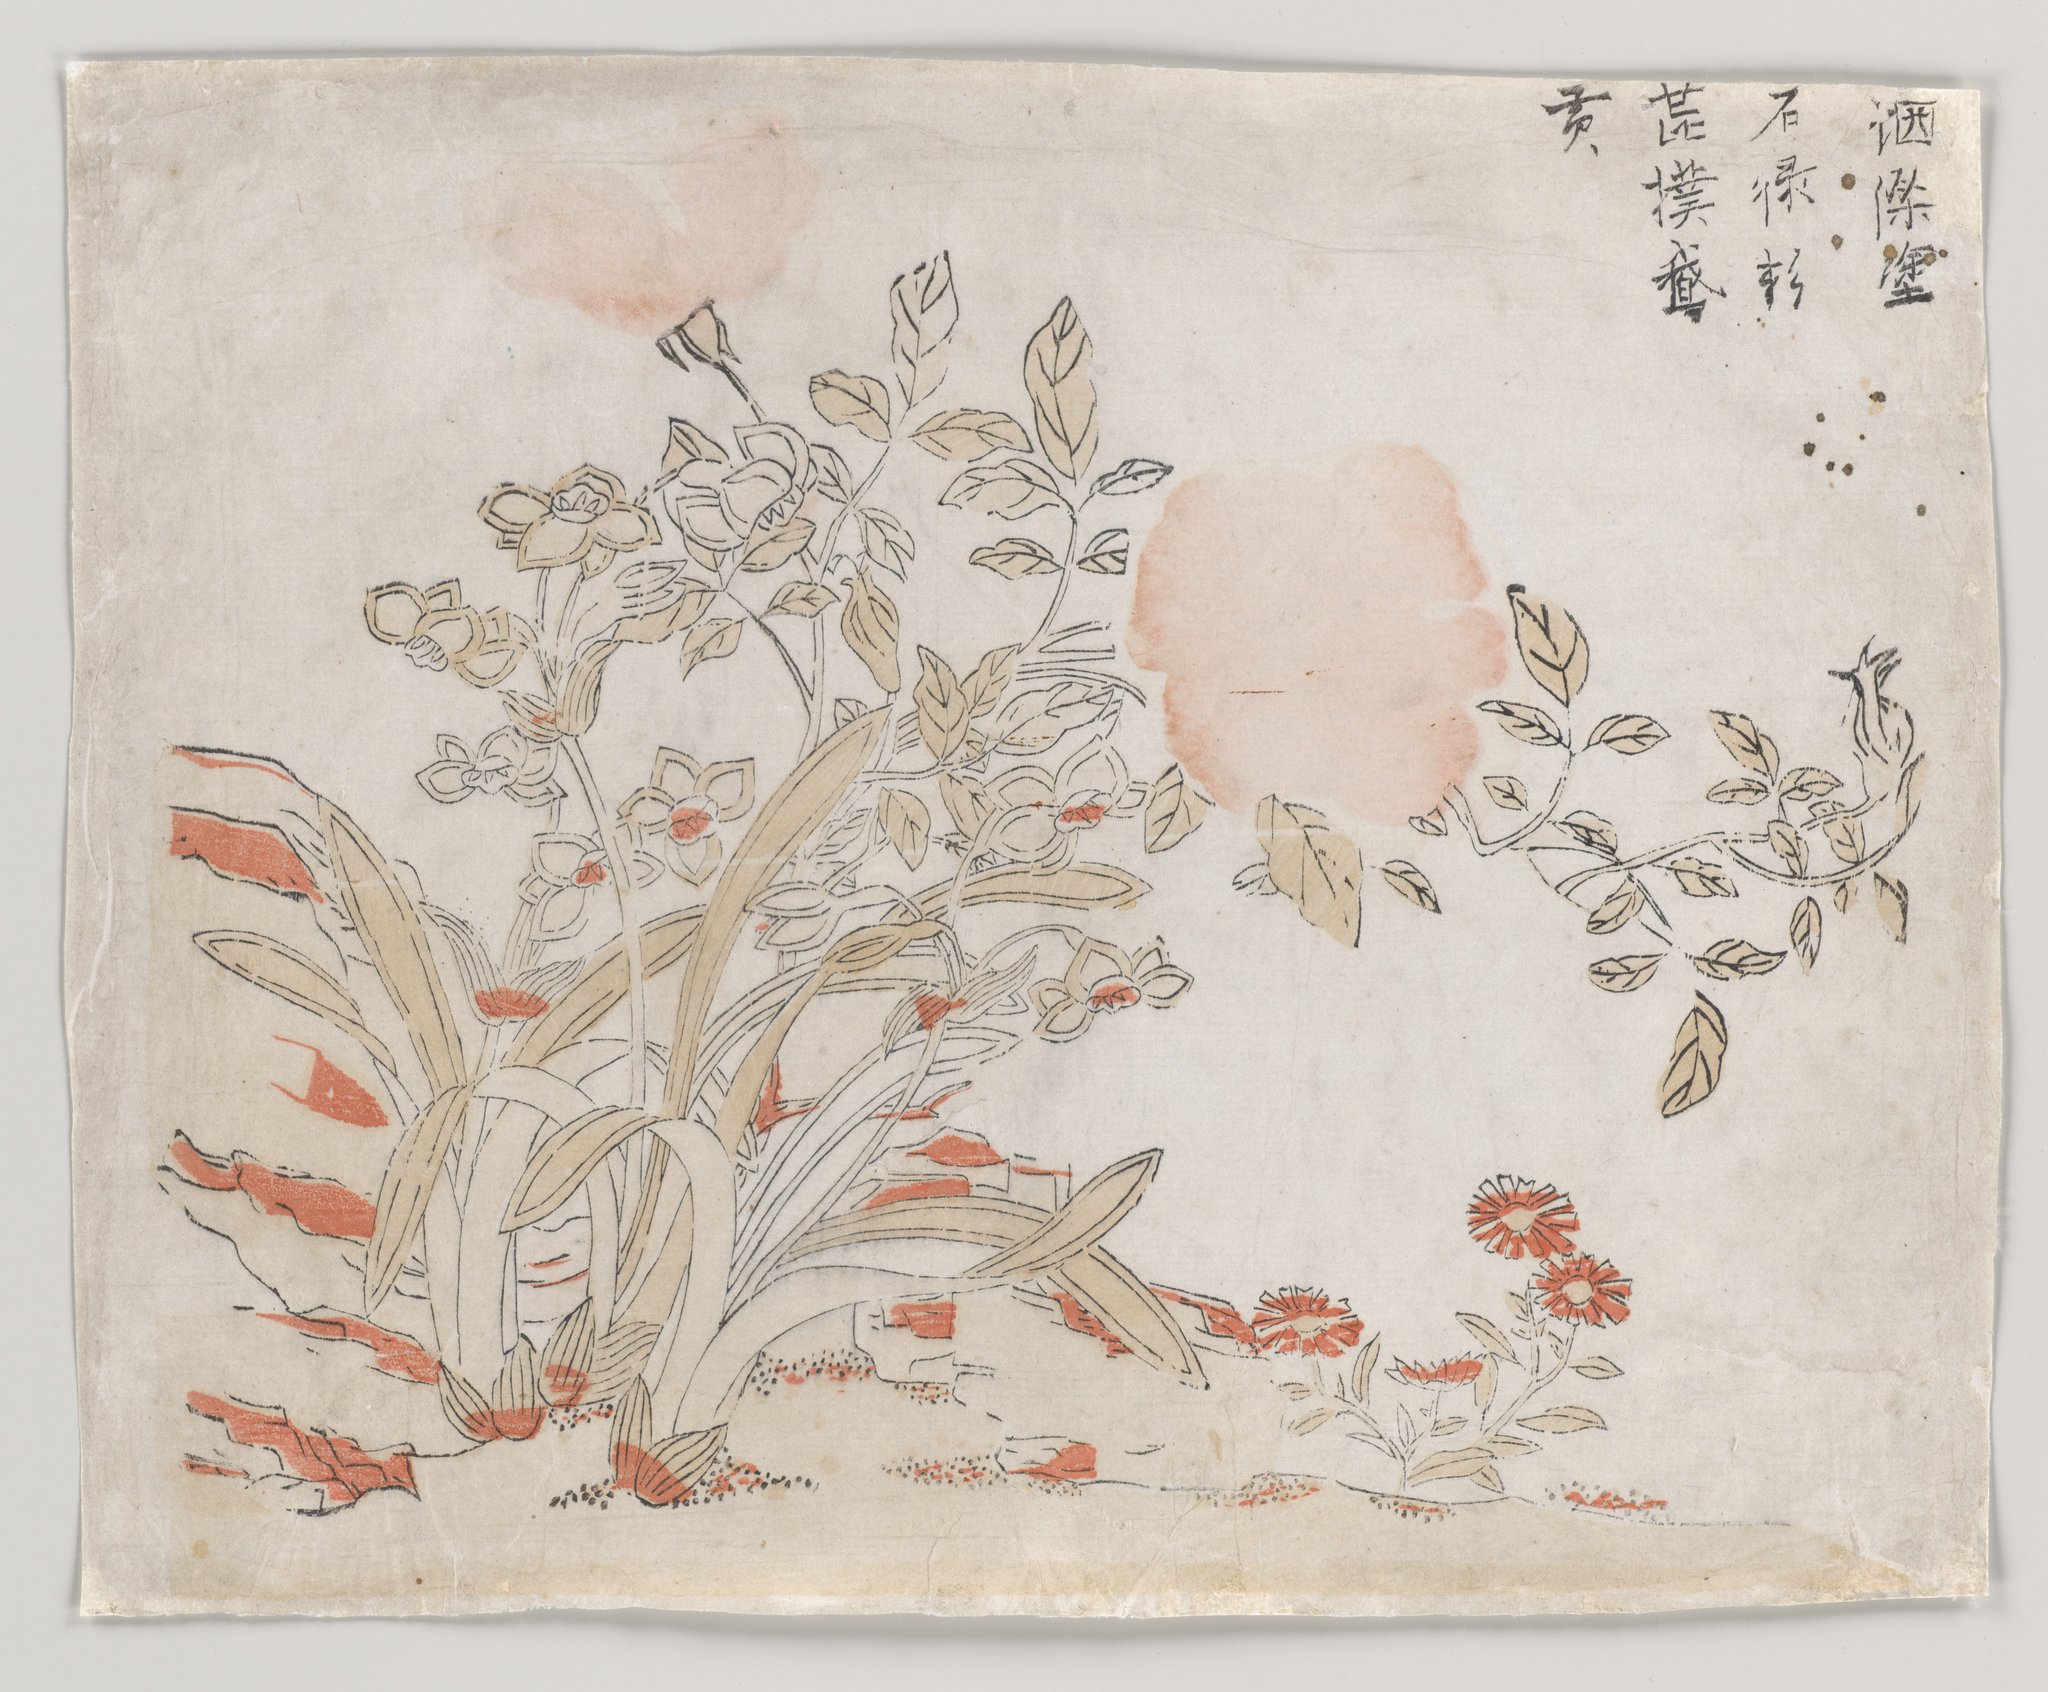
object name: print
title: Roses?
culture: chinese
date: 1701-1800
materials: ink, paper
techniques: polychrome, woodblock print